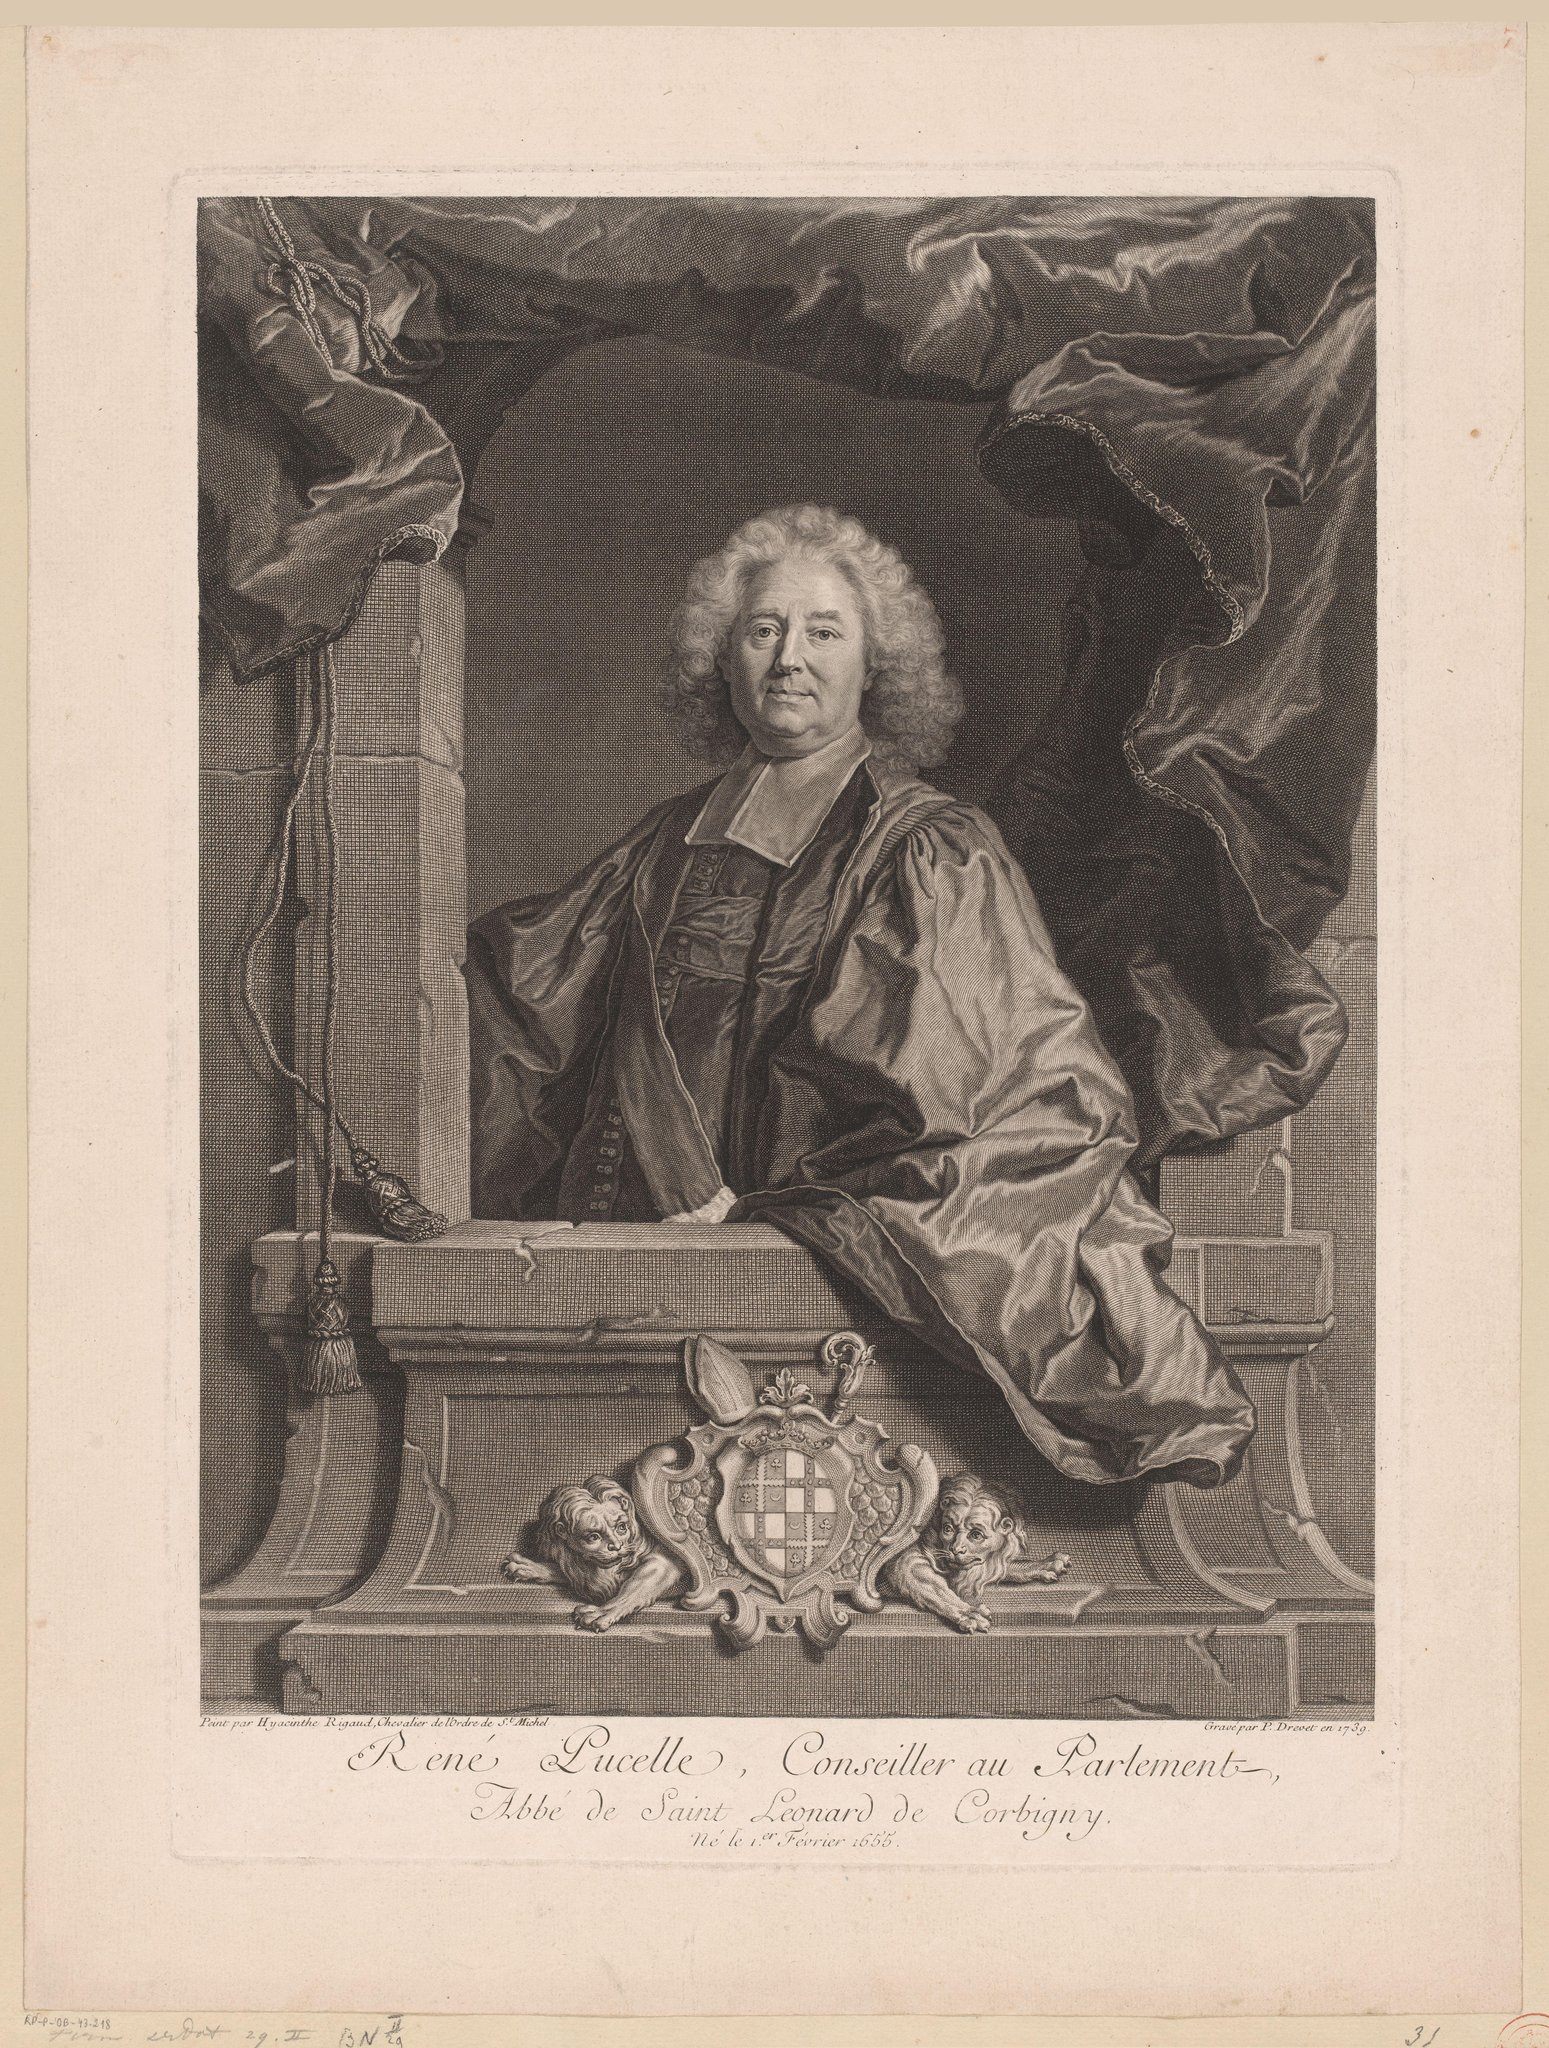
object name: print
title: René Pucelle, Conseiller au Parlement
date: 1739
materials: paper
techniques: engraving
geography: france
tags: paris, historical persons, human figure at (open) window, seen from outside - aa - feigned window, armorial bearing, heraldry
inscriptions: collector's mark: Lugt 240